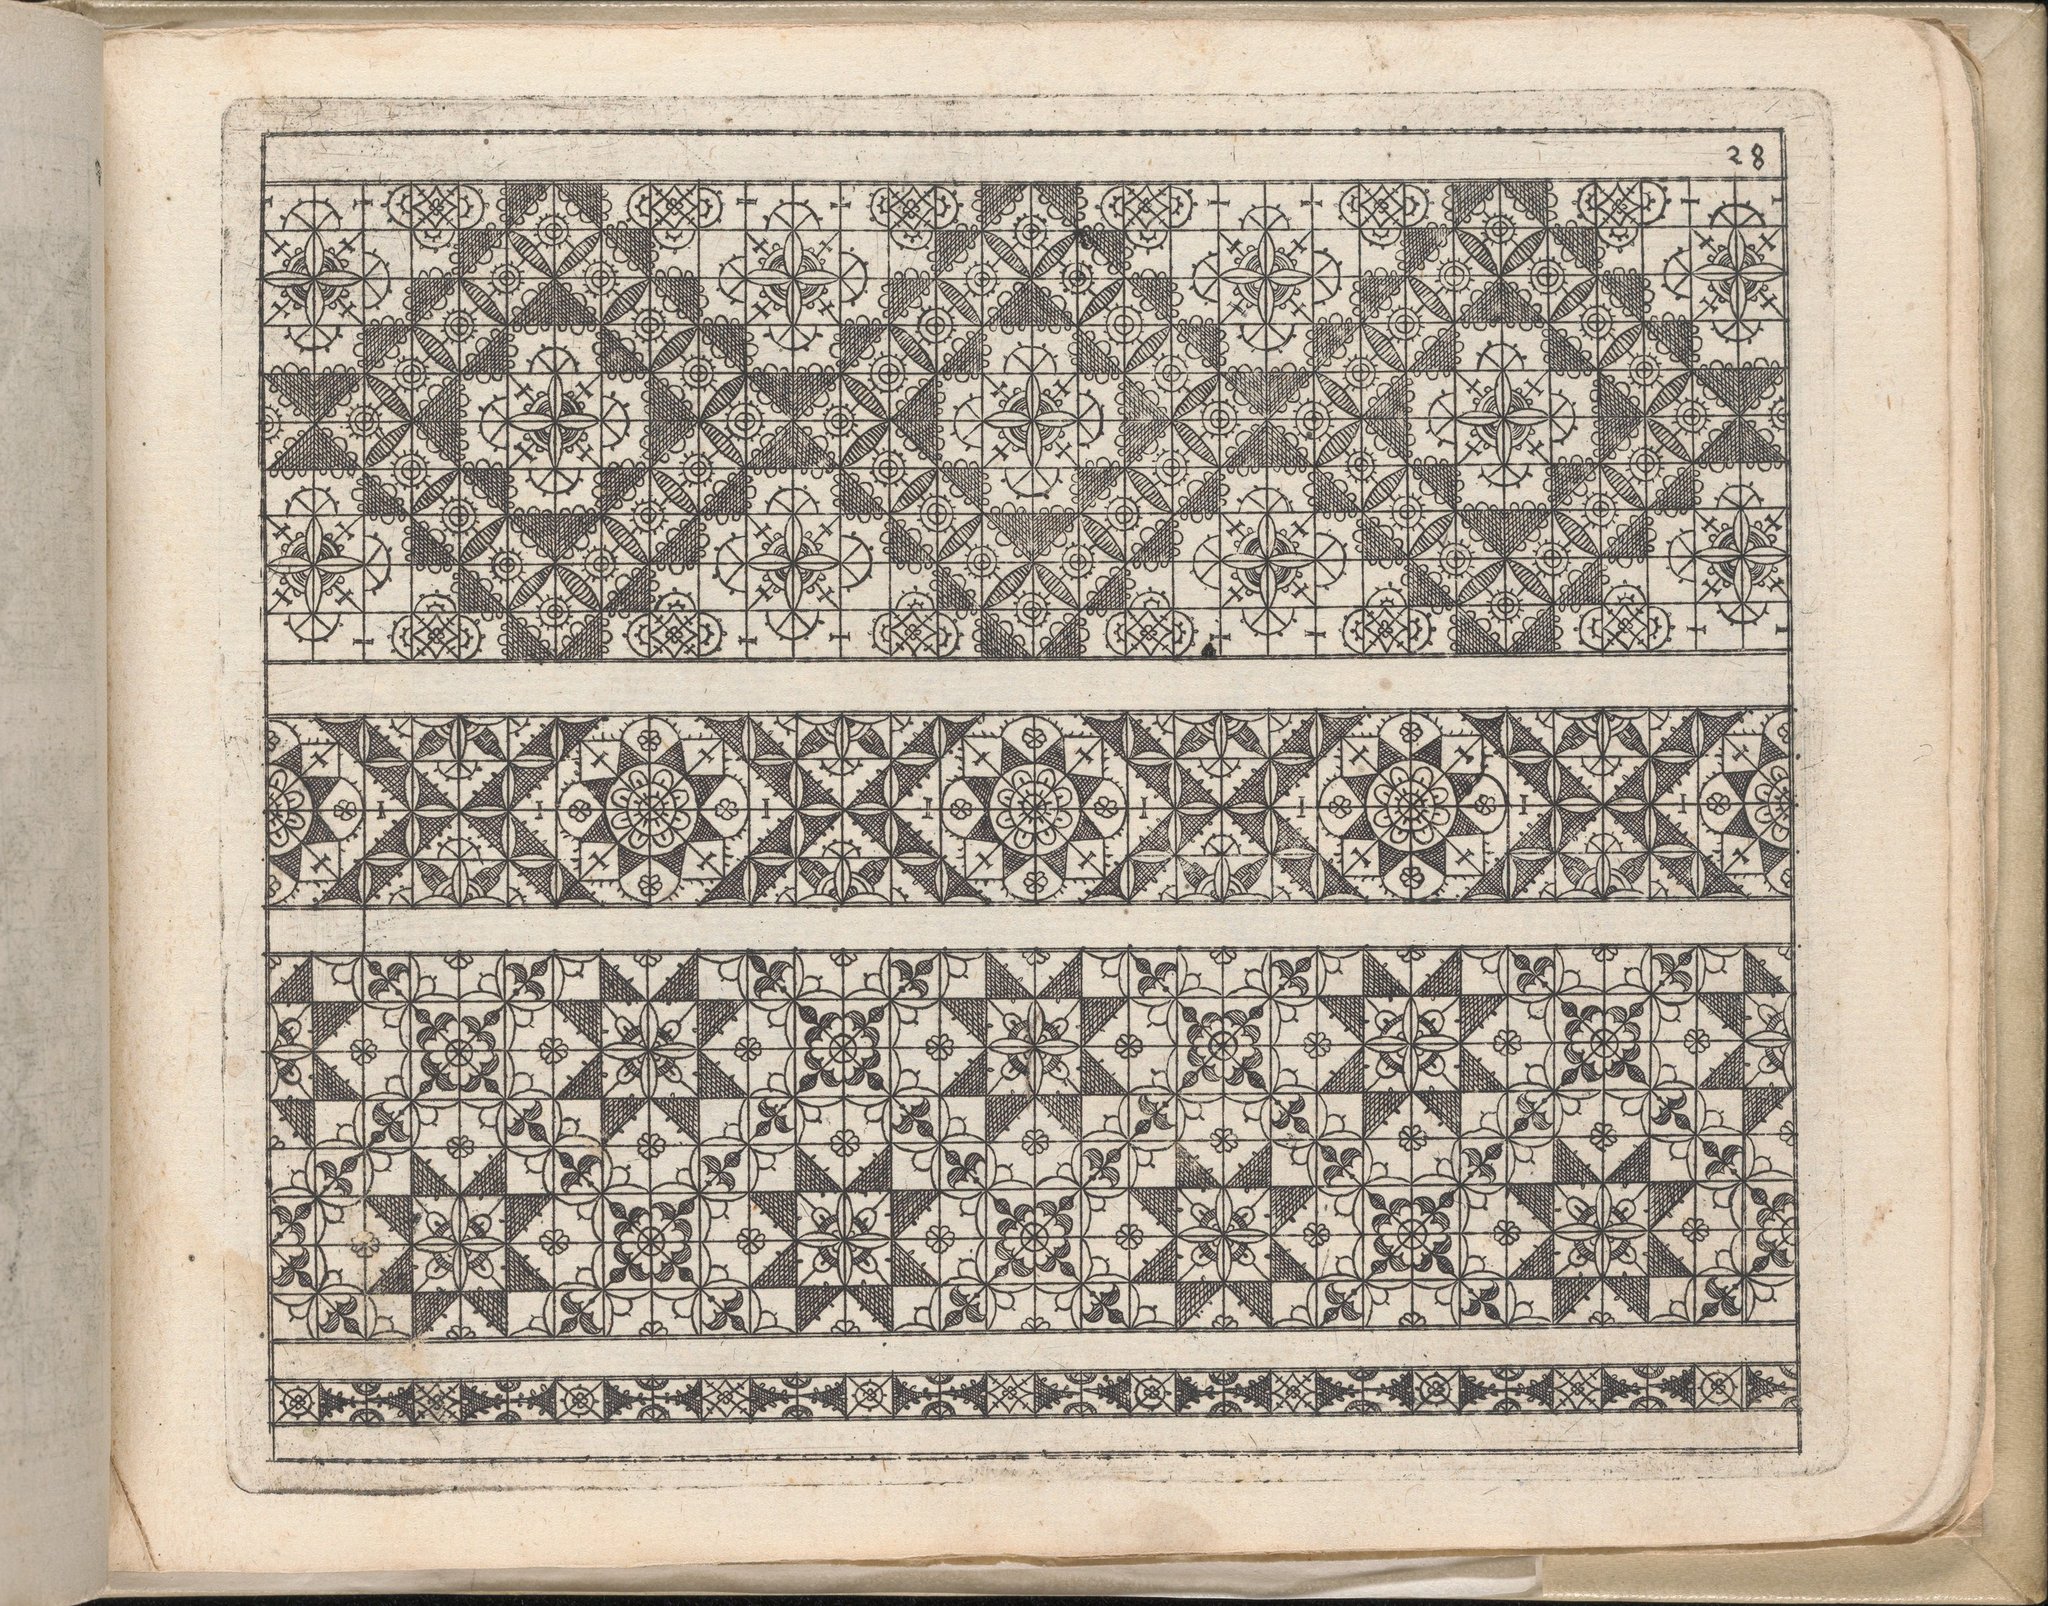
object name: book print ornament architecture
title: Schön Neues Modelbuch (Page 33 recto)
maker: johann sibmacher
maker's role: designer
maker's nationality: german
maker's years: 1590-1611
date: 1597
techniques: etching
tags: ornament